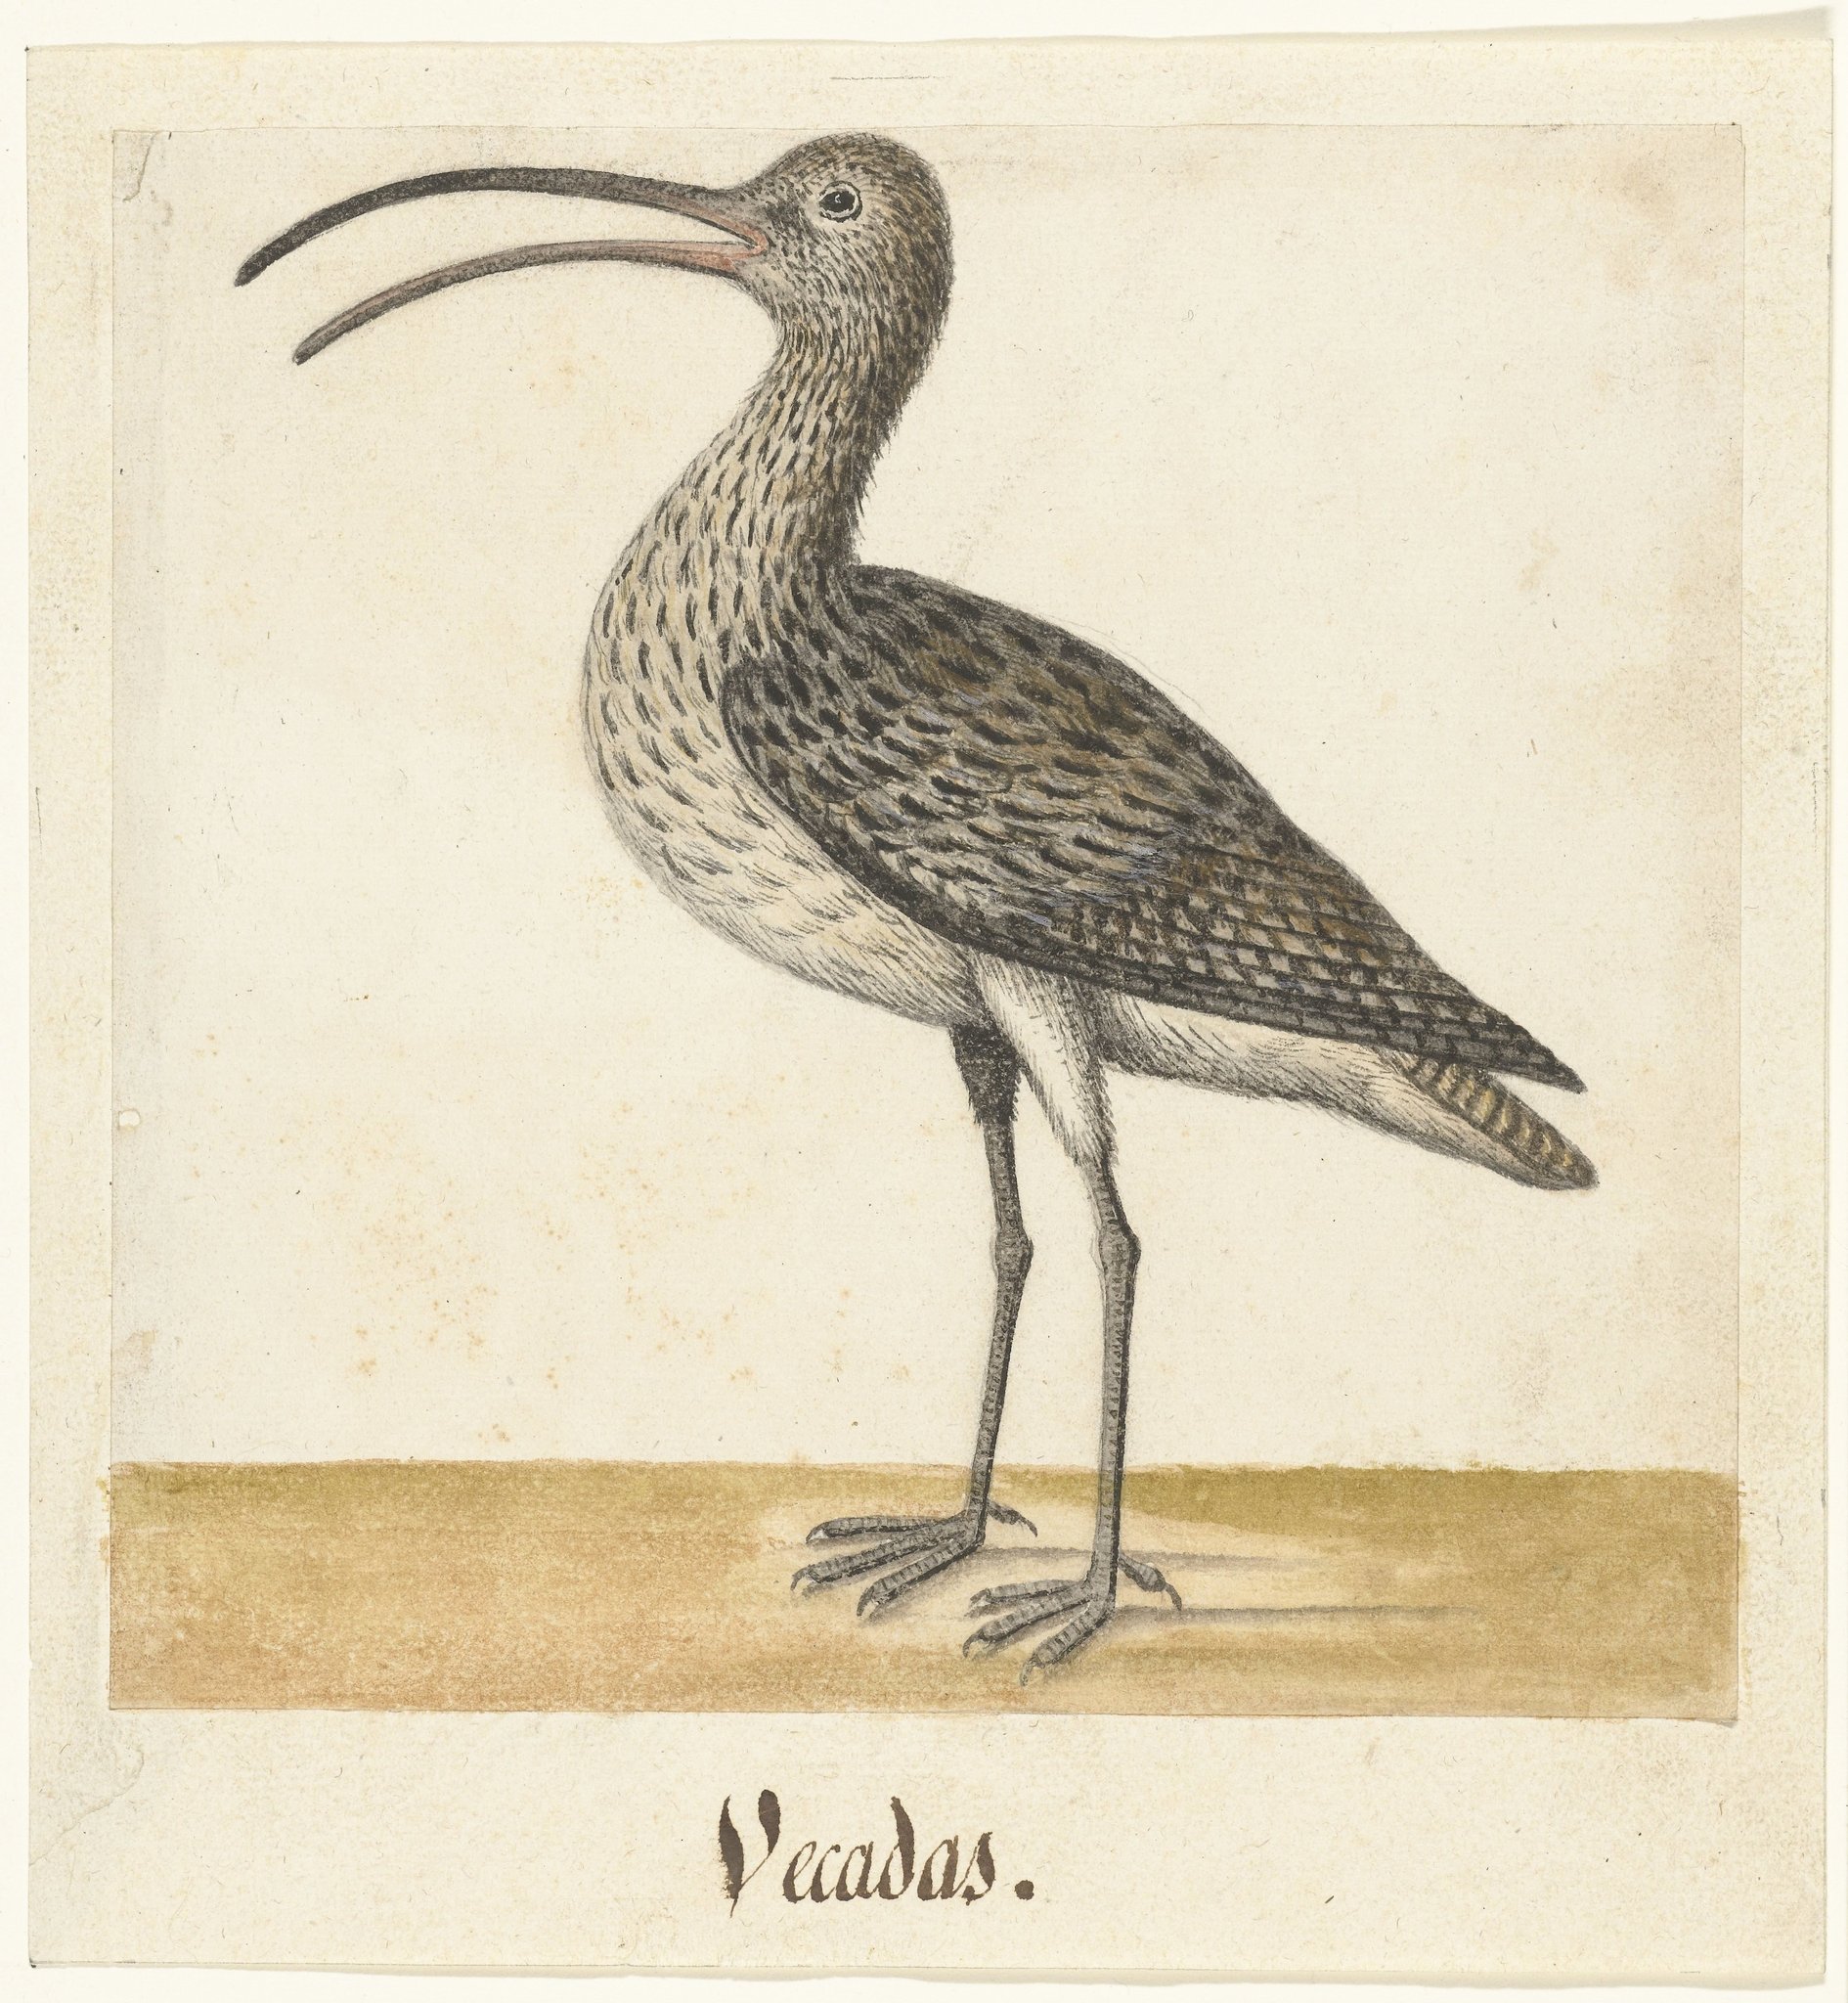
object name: drawing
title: Wulp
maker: Anonymous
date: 1560-1585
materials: paper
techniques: brush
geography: low countries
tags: shore-birds and wading-birds: curlew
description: Blad uit album van 100 (?) bladen met tekeningen van dieren.